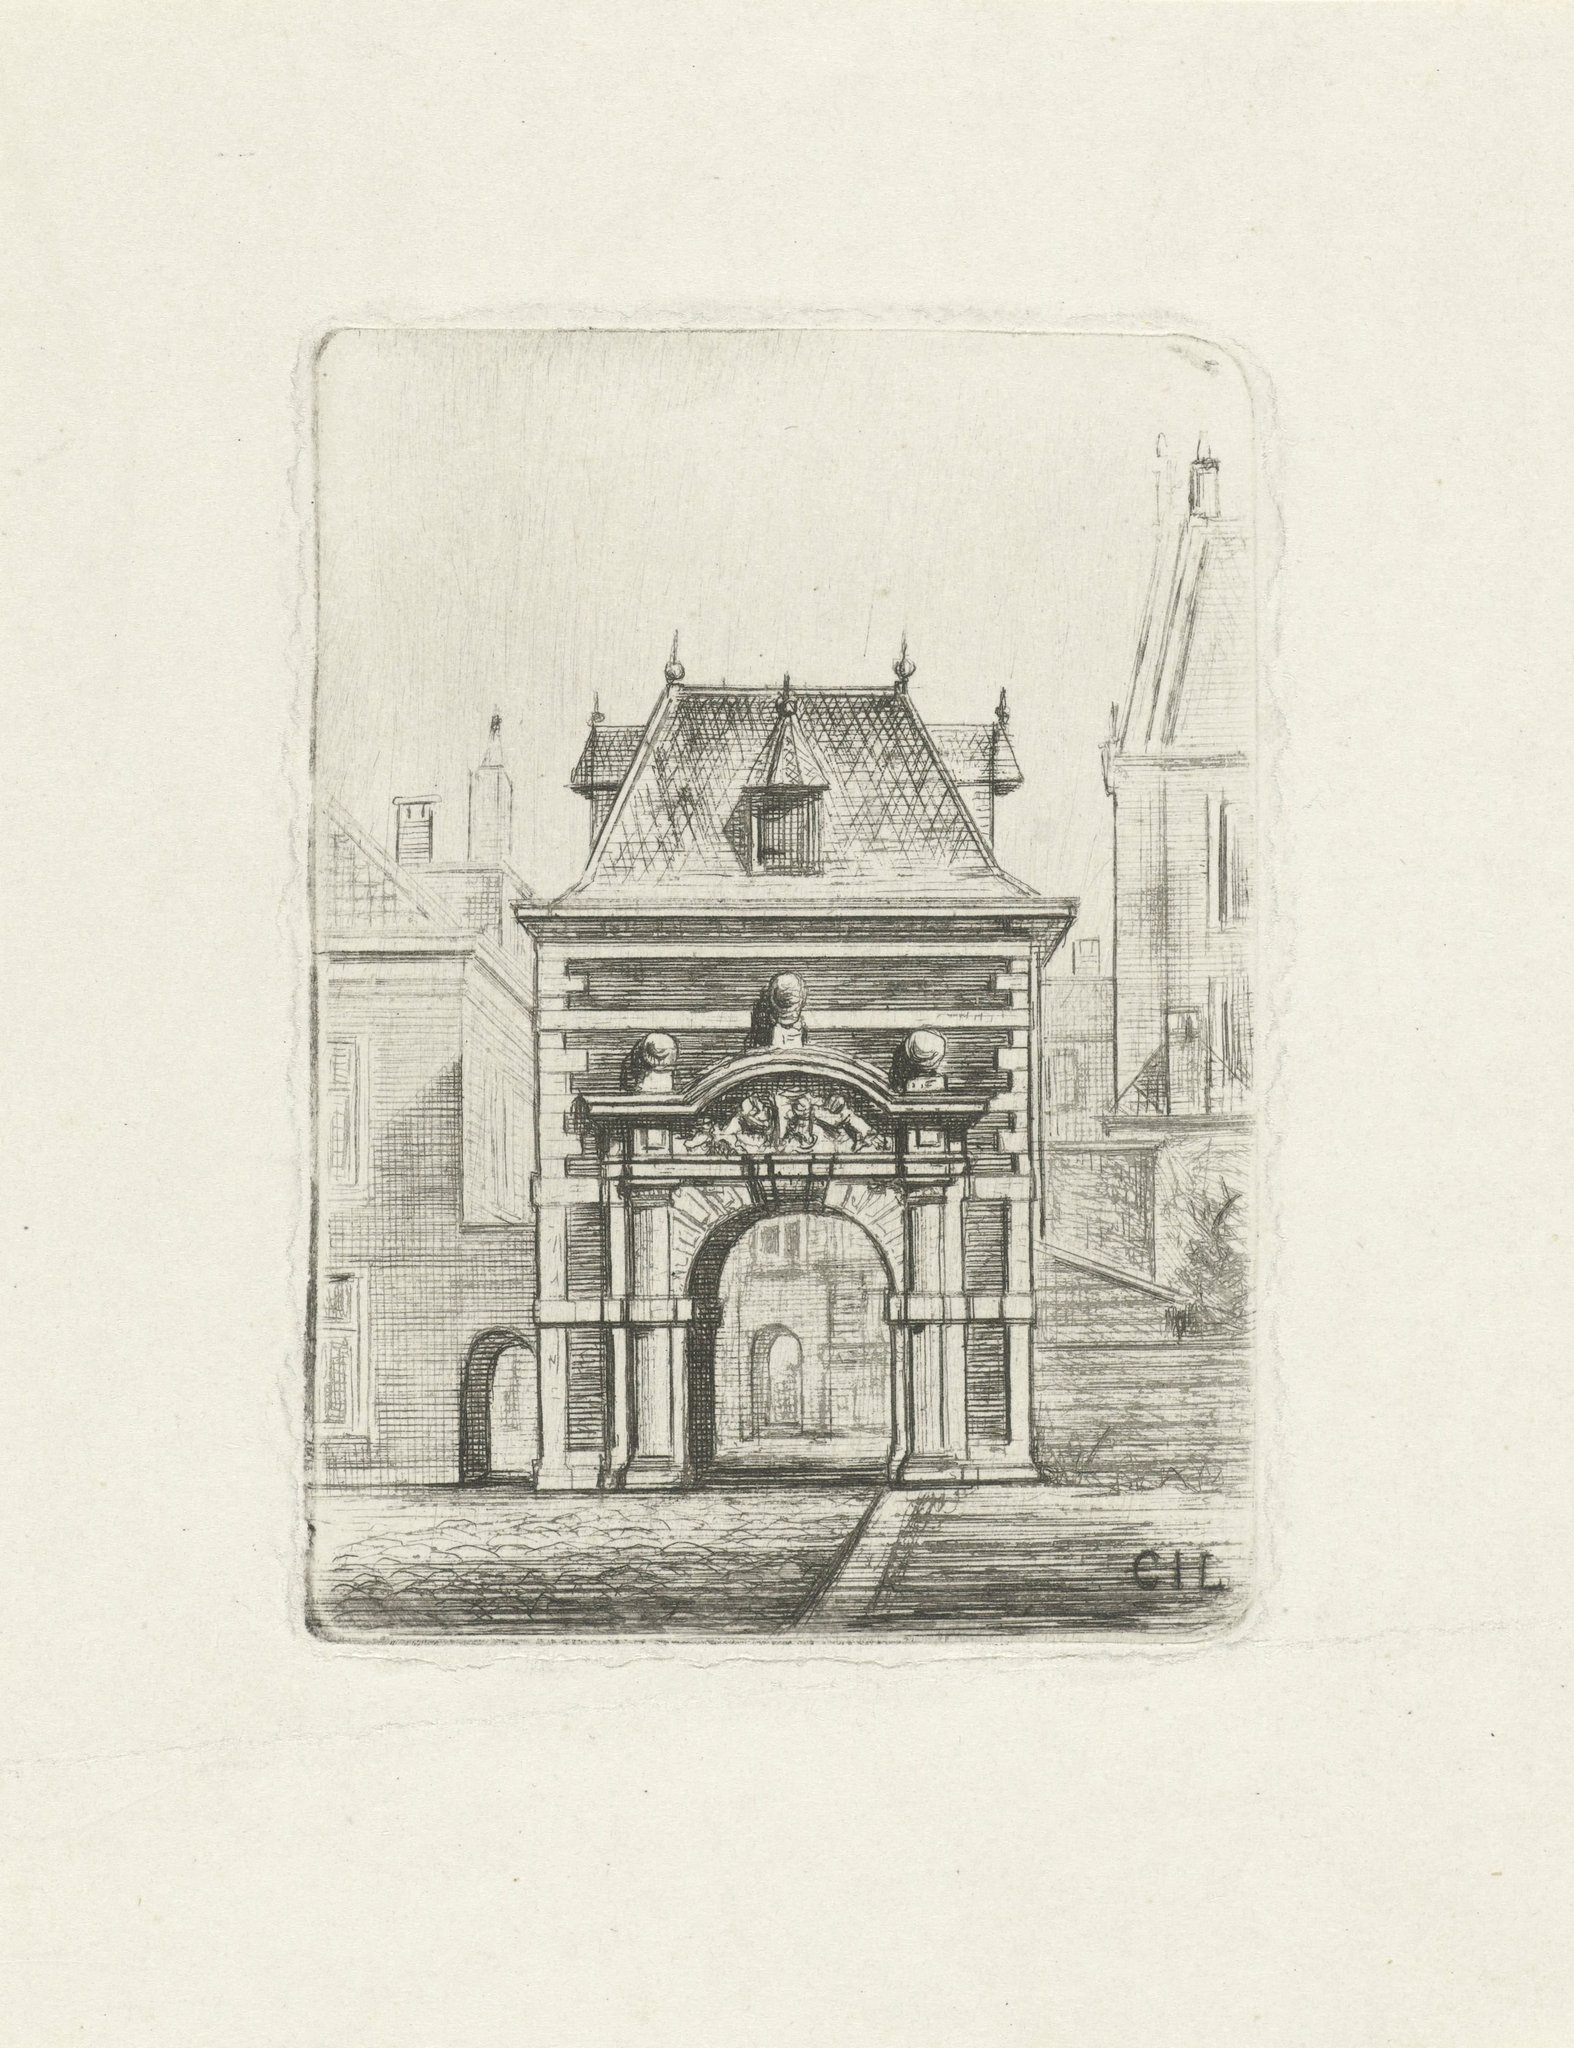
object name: print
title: Poort op het Binnenhof te Den Haag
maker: cornelis johan laarman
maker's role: print maker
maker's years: 1844-1889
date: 1854-1887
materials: paper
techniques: etching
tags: gate, entrance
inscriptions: collector's mark: Lugt 2228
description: Gezicht op een van de poorten op het Binnenhof te Den Haag.